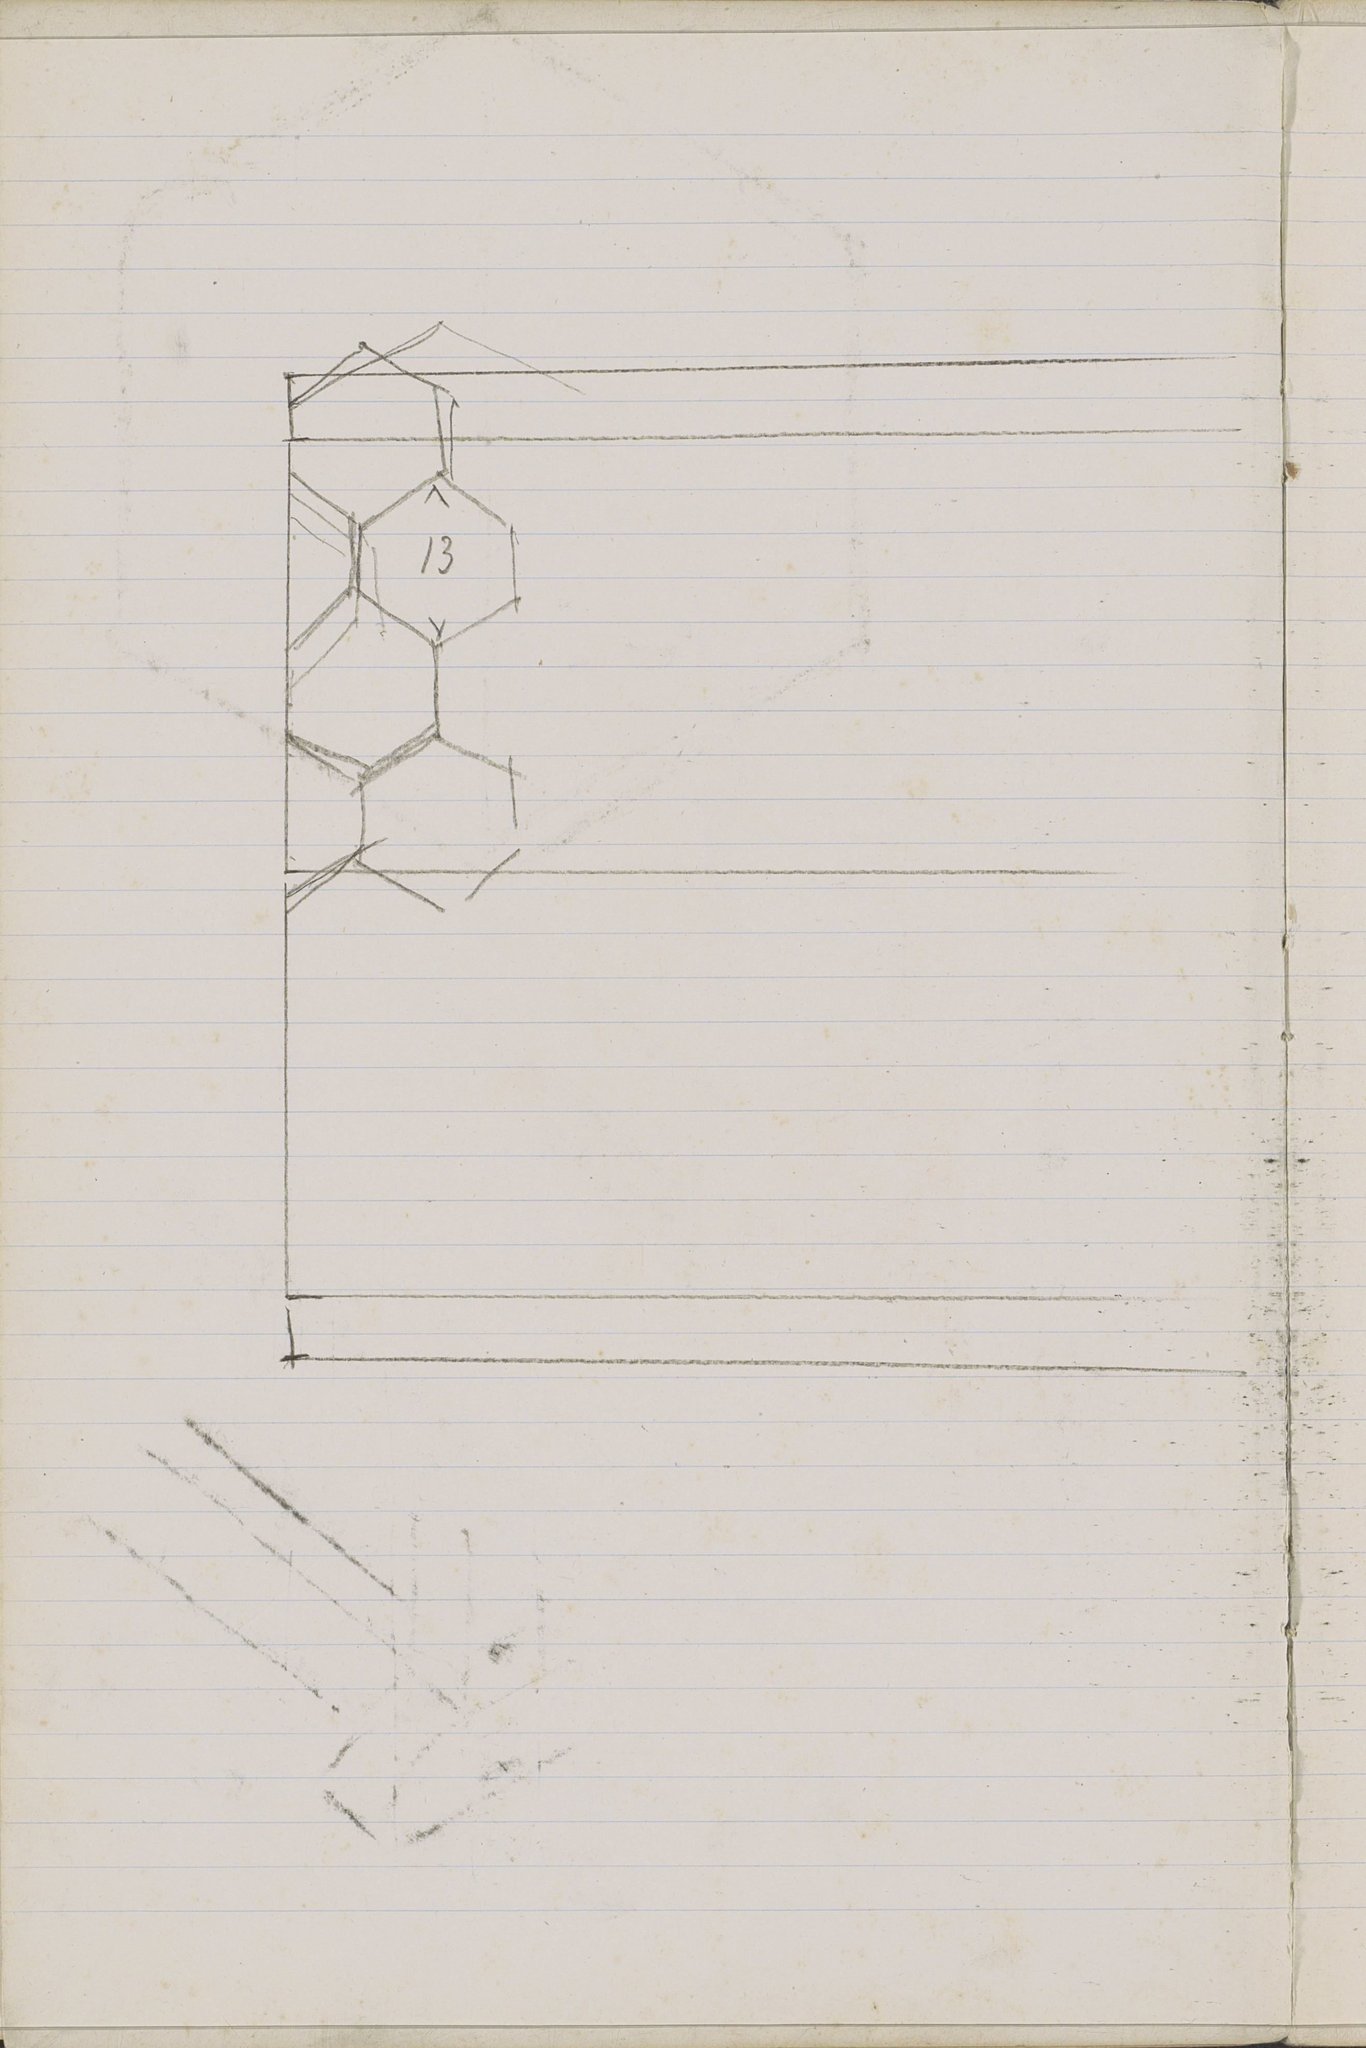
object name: sketchbook leaf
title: Ontwerp met honingraatpatroon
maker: gerrit willem dijsselhof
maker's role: designer, draughtsman, print maker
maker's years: 1866-1924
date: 1901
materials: pencil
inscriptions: annotation: ‘13’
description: Blad 2 verso uit een schetsboek met 79 bladen.